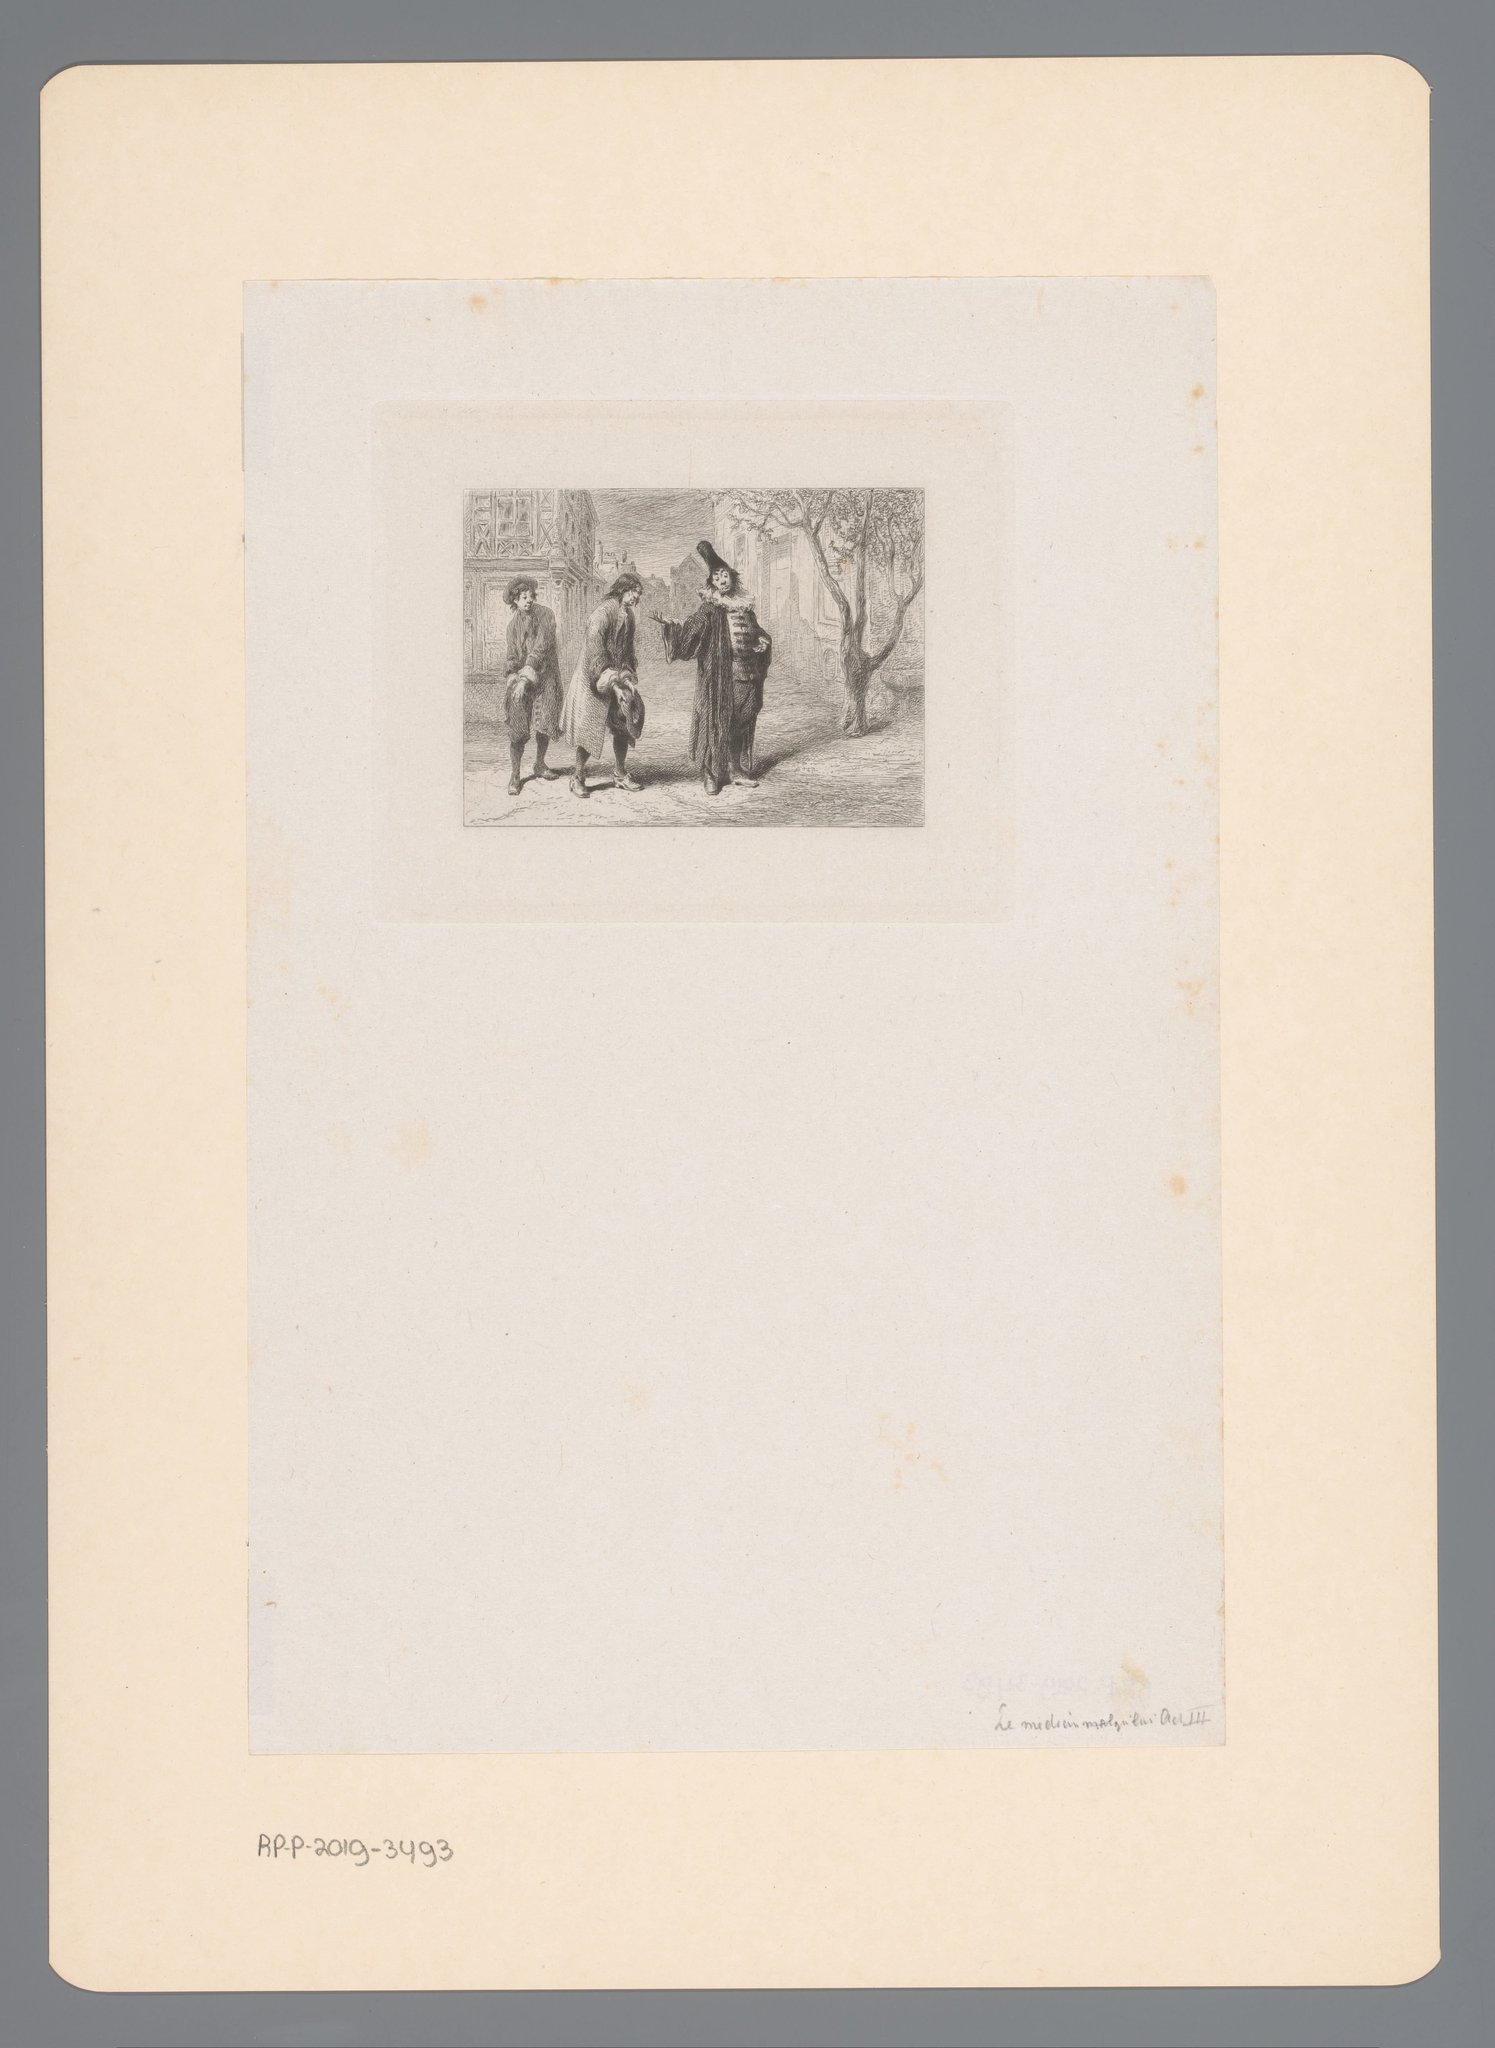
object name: print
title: Toneelstukken van Molière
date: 1878-1879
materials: paper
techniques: drypoint, etching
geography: tours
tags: theatre, theatrical performance, physician, doctor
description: Akte III, scène II uit "Le Médecin Malgré Lui" van Molière. Thibaut vraagt Sganarelle om naar zijn vrouw Parette te kijken, die ziek is. Naast hen staat Thibauts zoon Perrin.